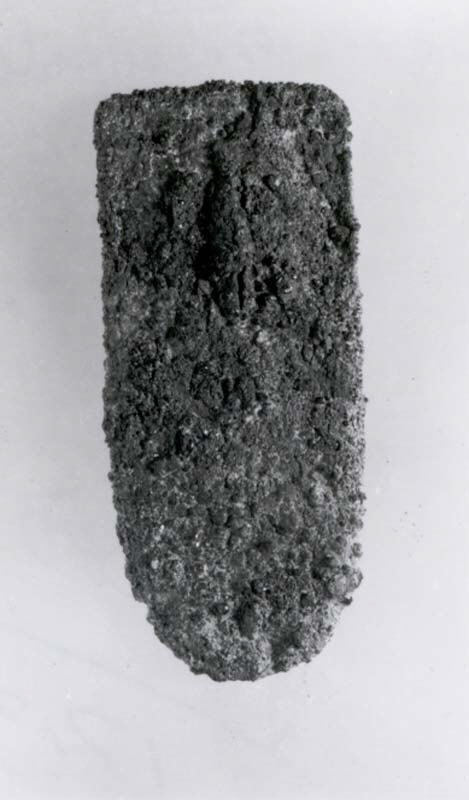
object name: armor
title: Armor plate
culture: assyrian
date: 734-601 BCE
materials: iron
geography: mesopotamia